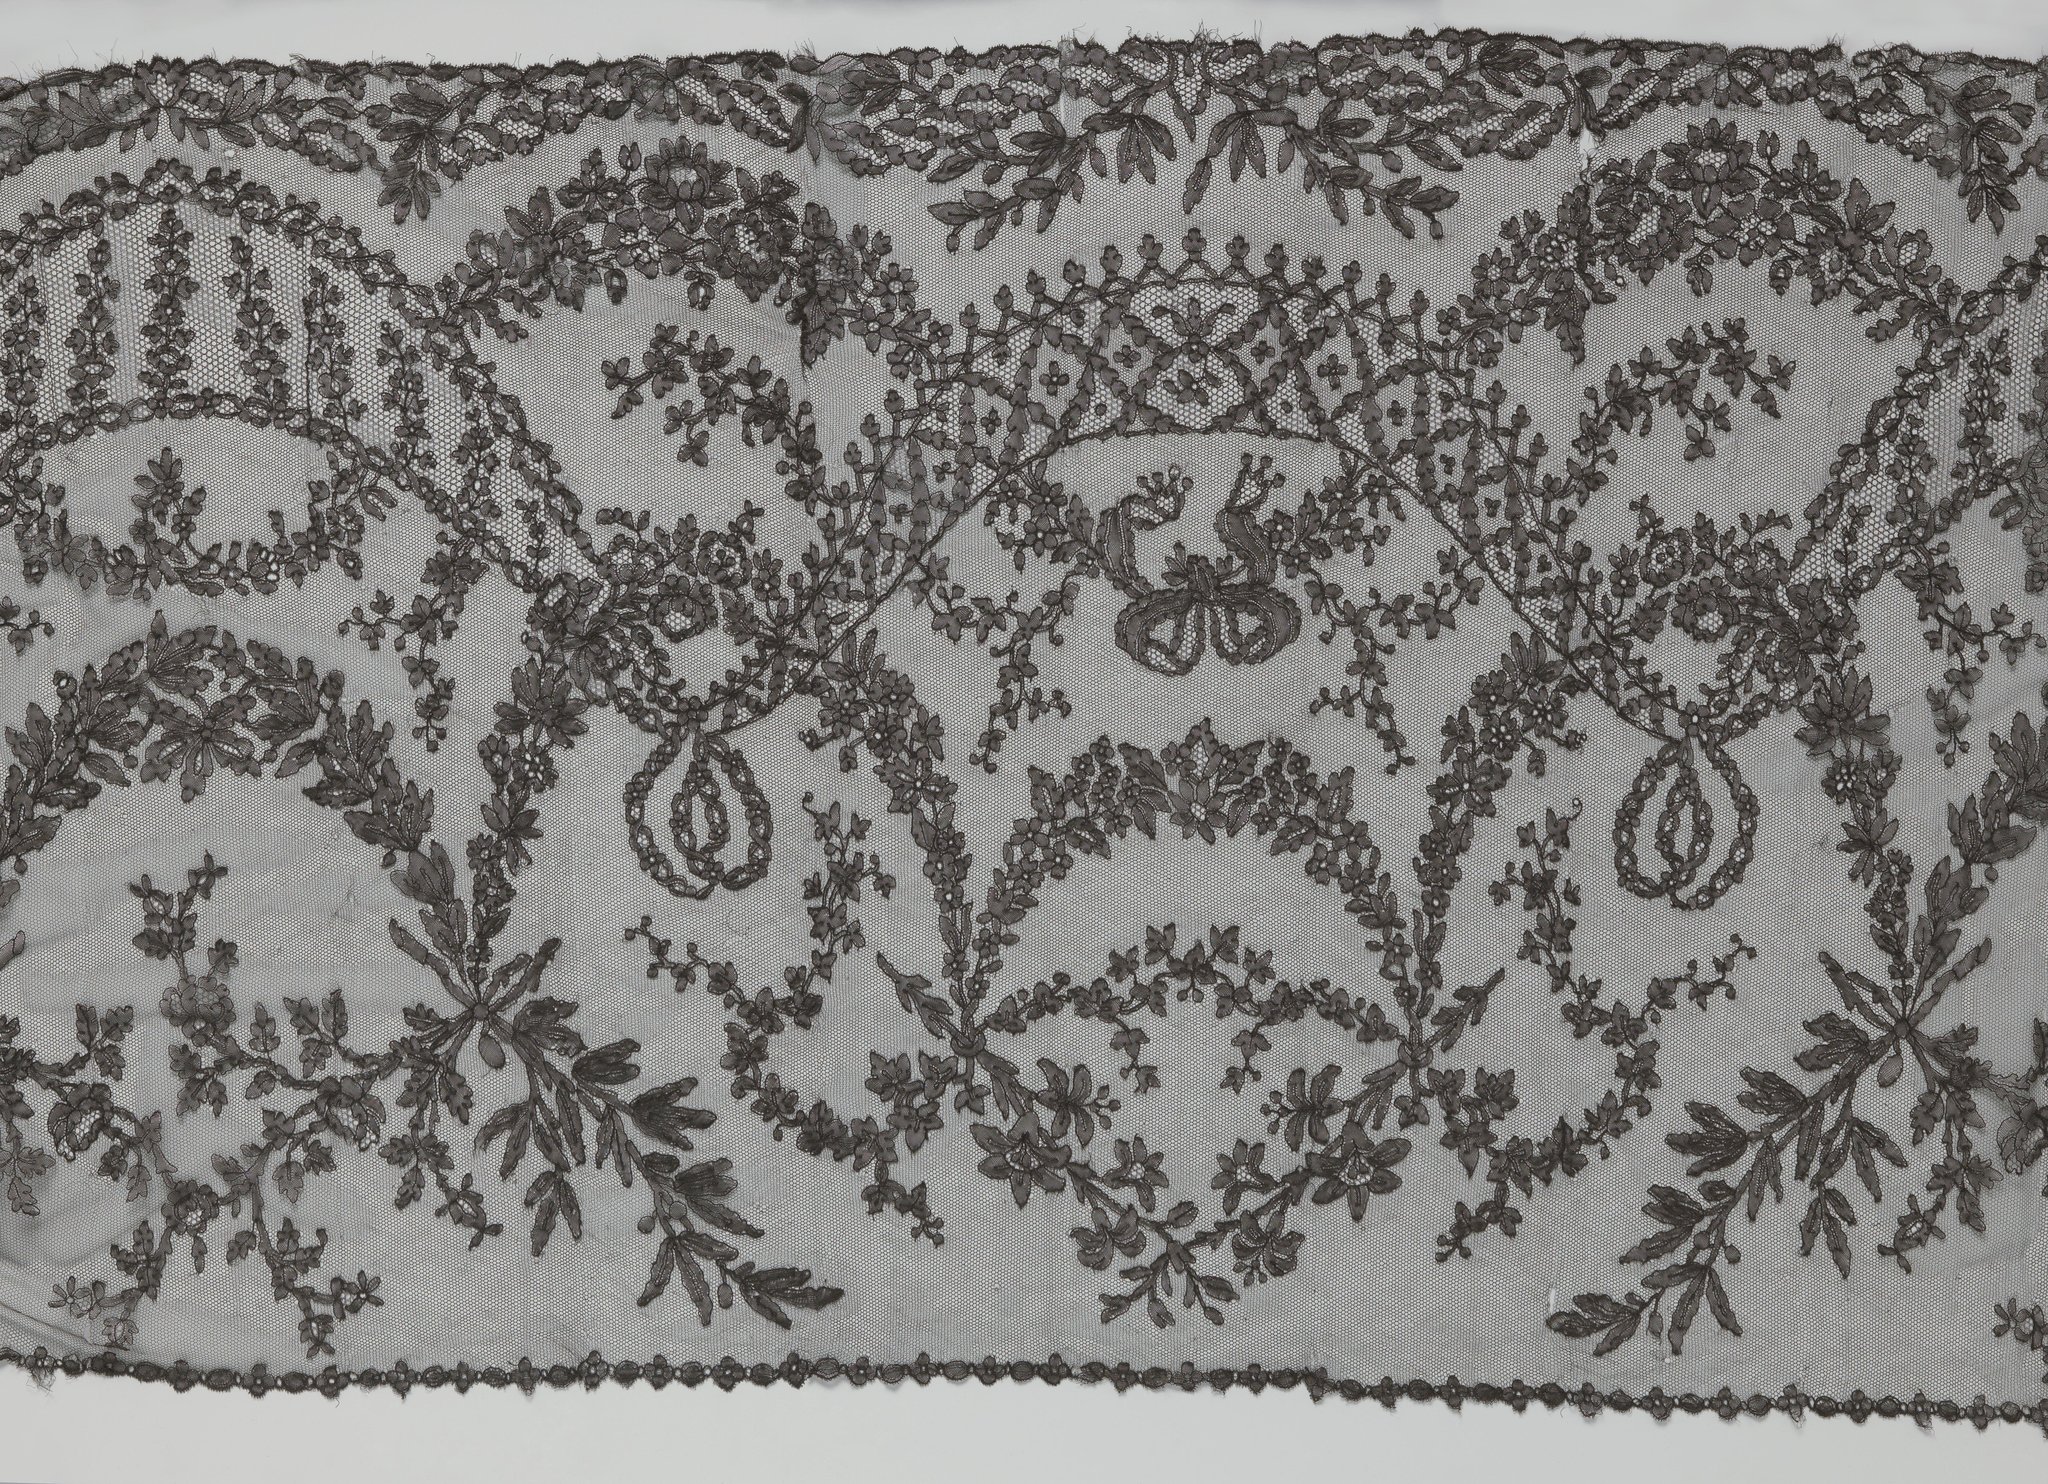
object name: japonstrook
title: Japonstrook van kloskant met festoenen en guirlandes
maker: Anonymous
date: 1820-1830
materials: silk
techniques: lace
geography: geraardsbergen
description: Japonstrook van zwarte kloskant: Chantilly-kant. Op een grove traliegrond staat een symmetrisch en open decor van twee opengewerkte festoenen, hangende aan dubbele lussen. Langs de vrijwel rechte buitenrand loopt een kabelmotief, doorvlochten met bloemtakken. De ene festoen vertoont een ruitvulling, de andere dwarsstrepen van takjes. Deze festoenen worden doorkruist door twee bloem- en bladguirlandes, waarvan de onderste aan strikken hangt, terwijl de bovenste afhangt van gekruiste olijf- en klimopranken. De rechte binnenrand is afgewerkt met aaneengeschakelde sterbloempjes.